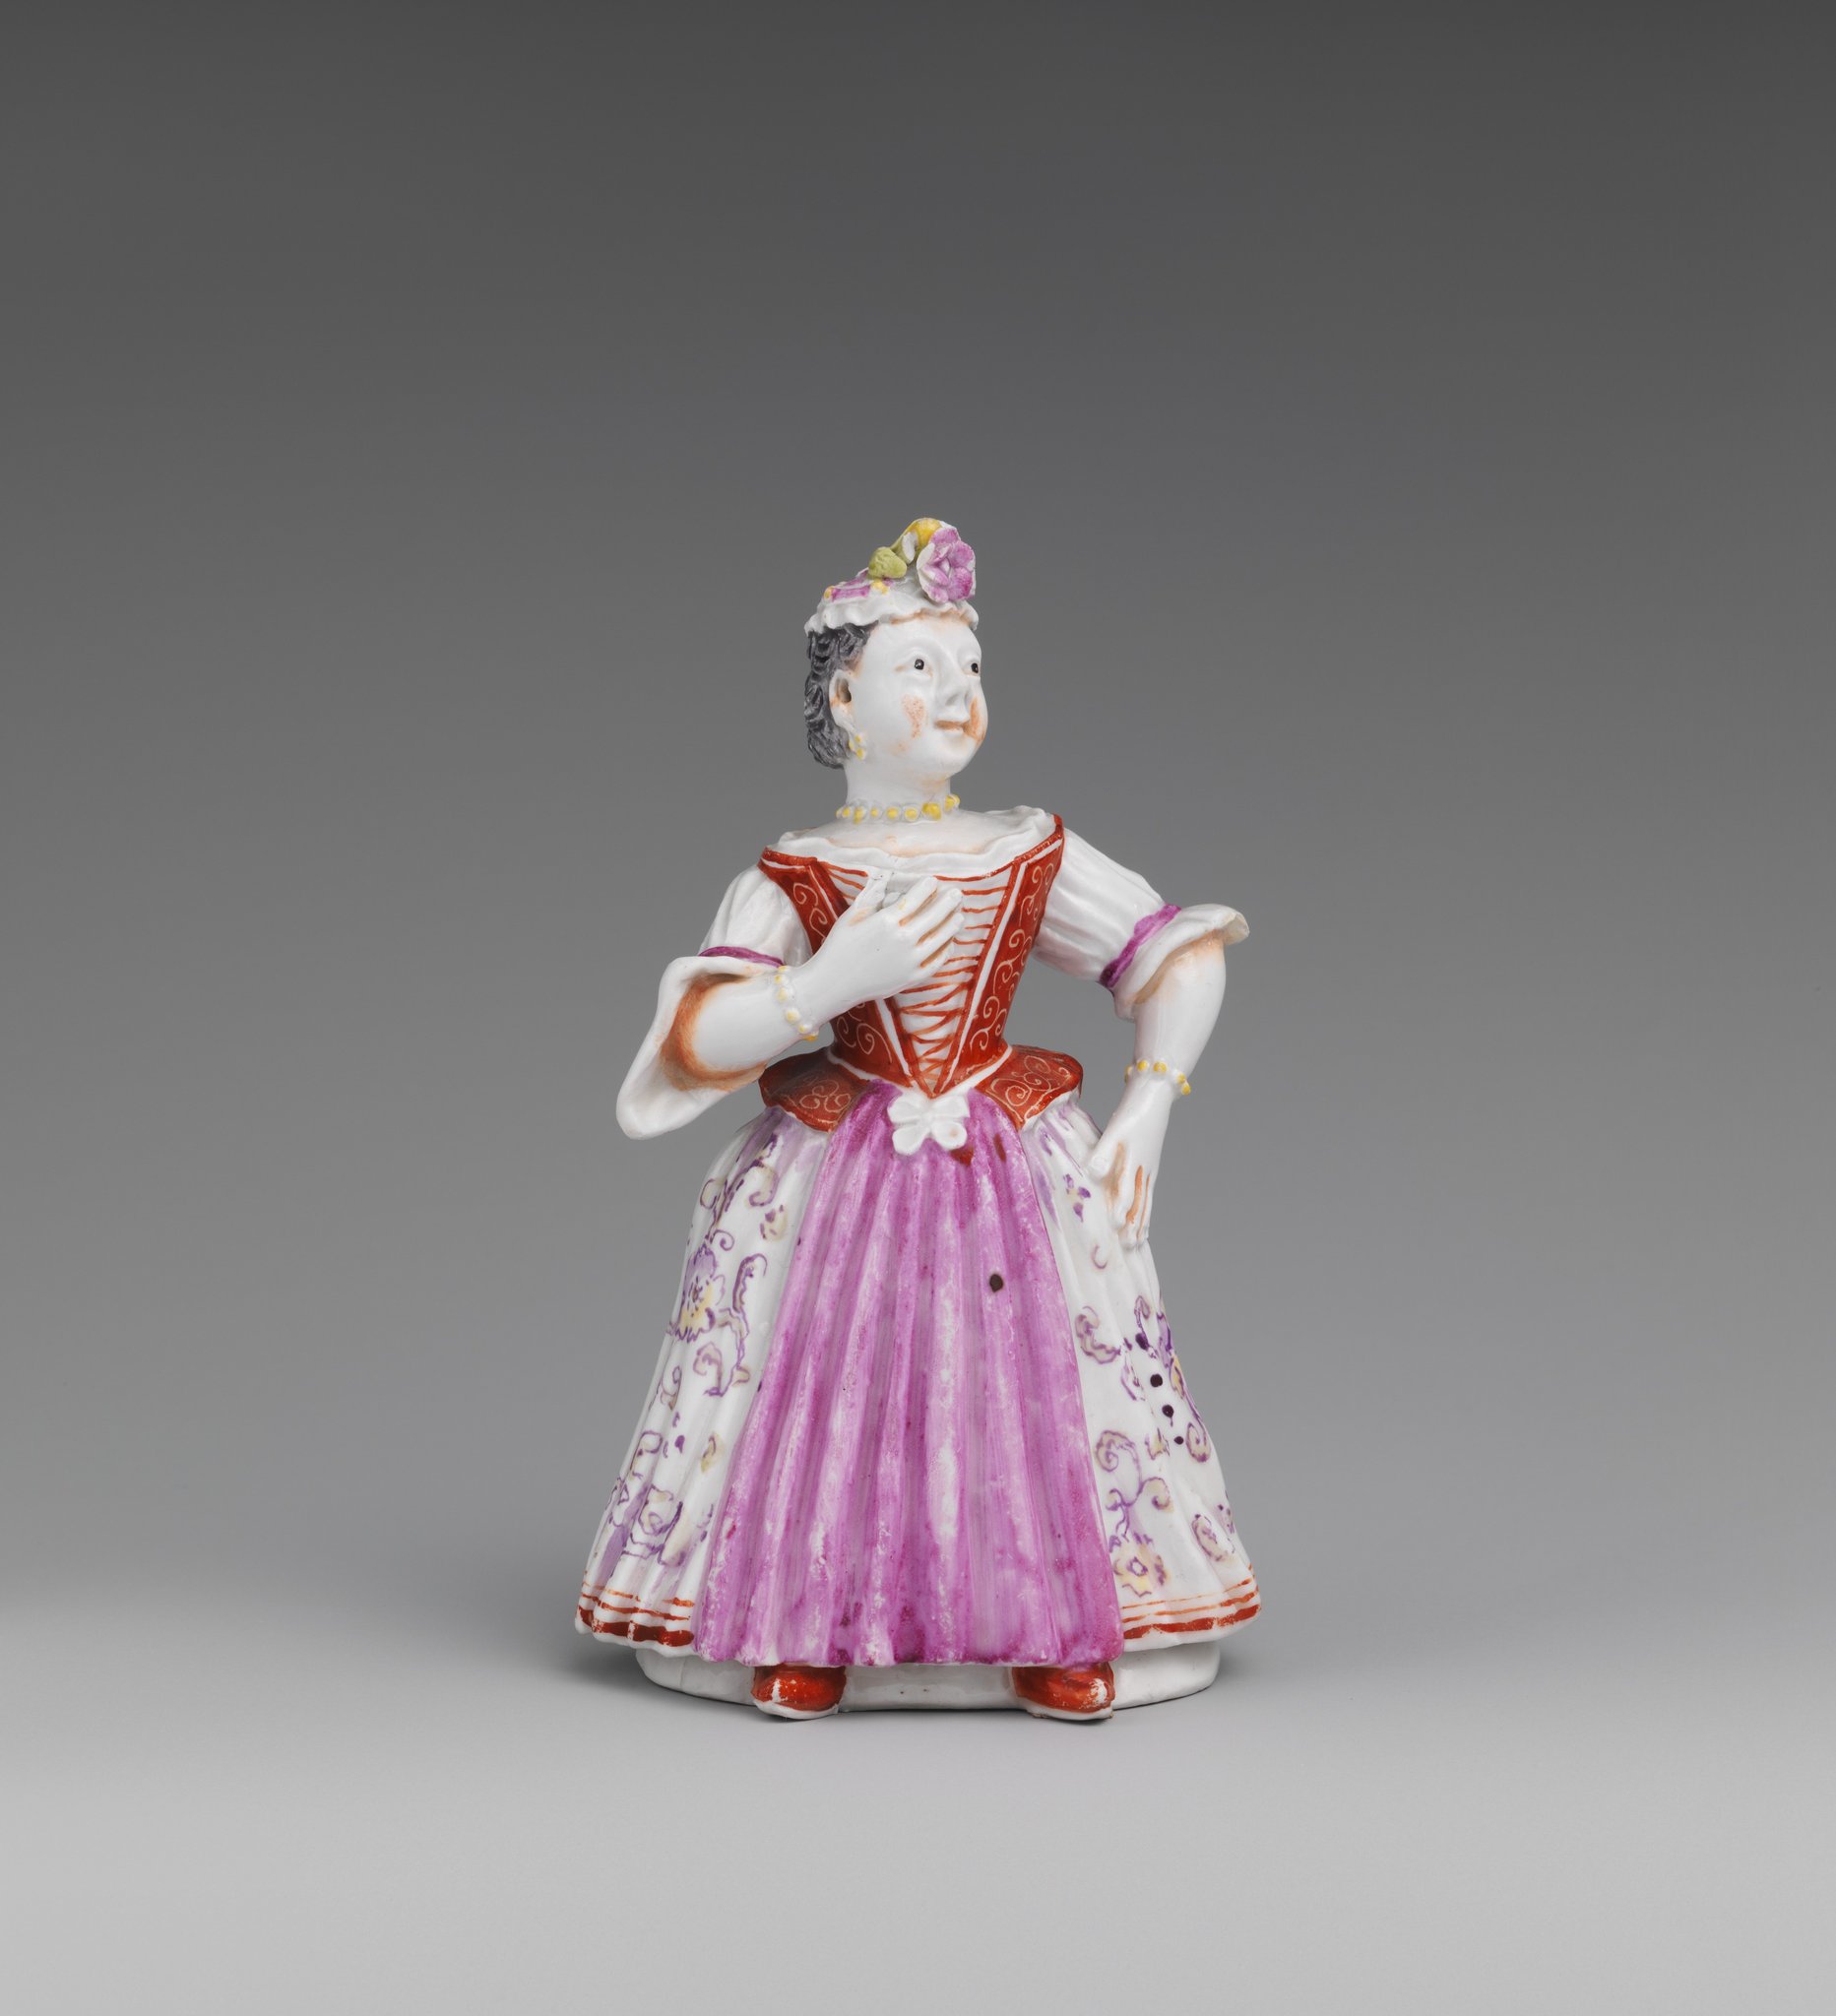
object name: table bell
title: Table Bell in the Form of a Chambermaid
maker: vienna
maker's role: manufactory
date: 1735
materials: hard paste porcelain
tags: women